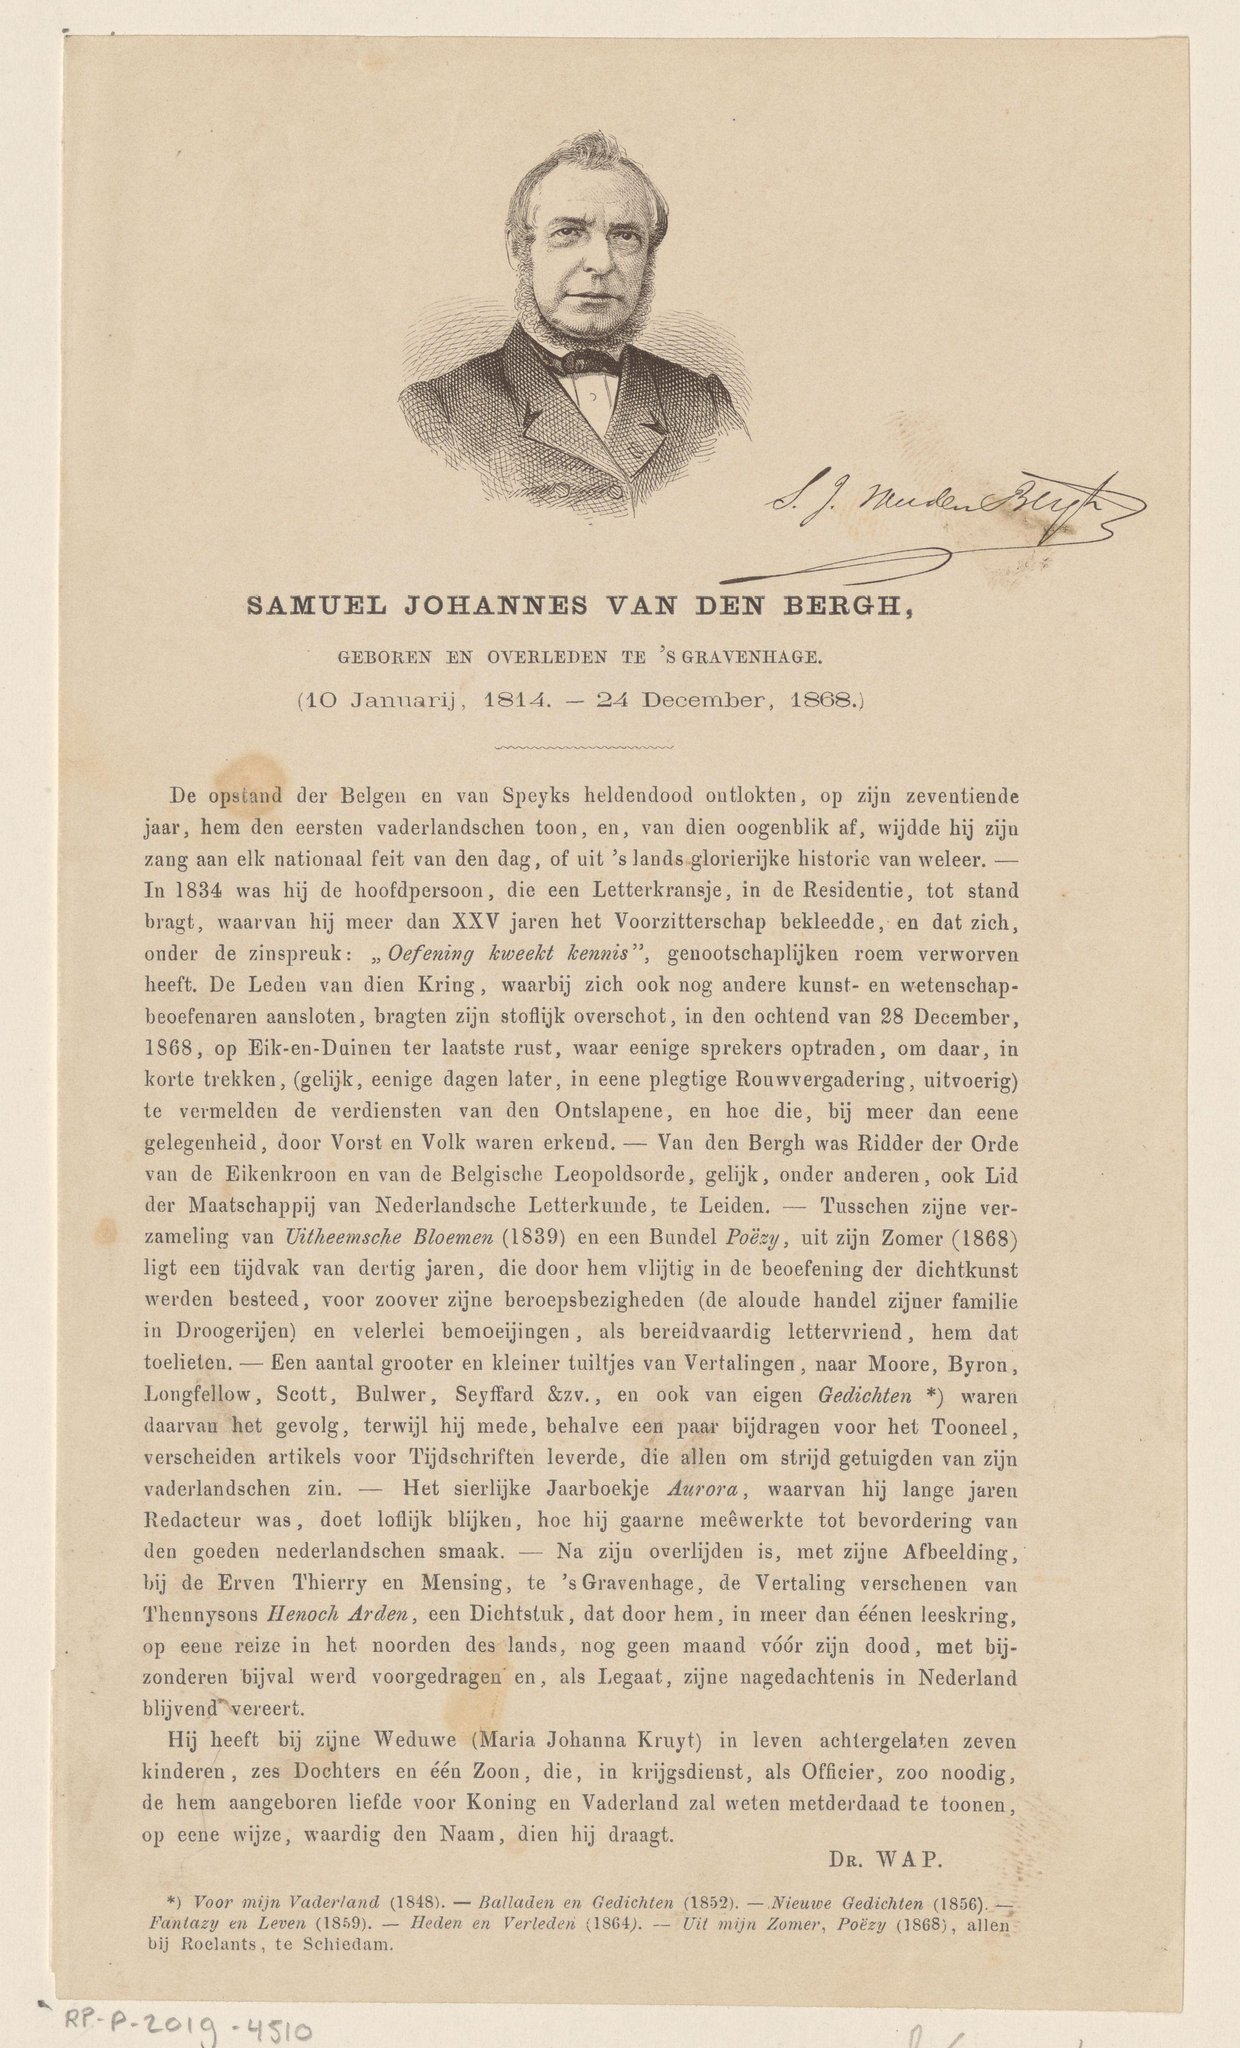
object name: print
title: Portret van Samuel Johannes van den Bergh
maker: Anonymous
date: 1869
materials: paper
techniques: letterpress printing, lithograph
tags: the hague, samuel johannes van den bergh, historical persons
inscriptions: collector's mark: Lugt 2228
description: Prent uit: Catalogus van schilderijen en teekeningen van levende meesters (...) nagelaten door den weled. heer S.J. van den Bergh. [Den Haag]: s.n., [1869].